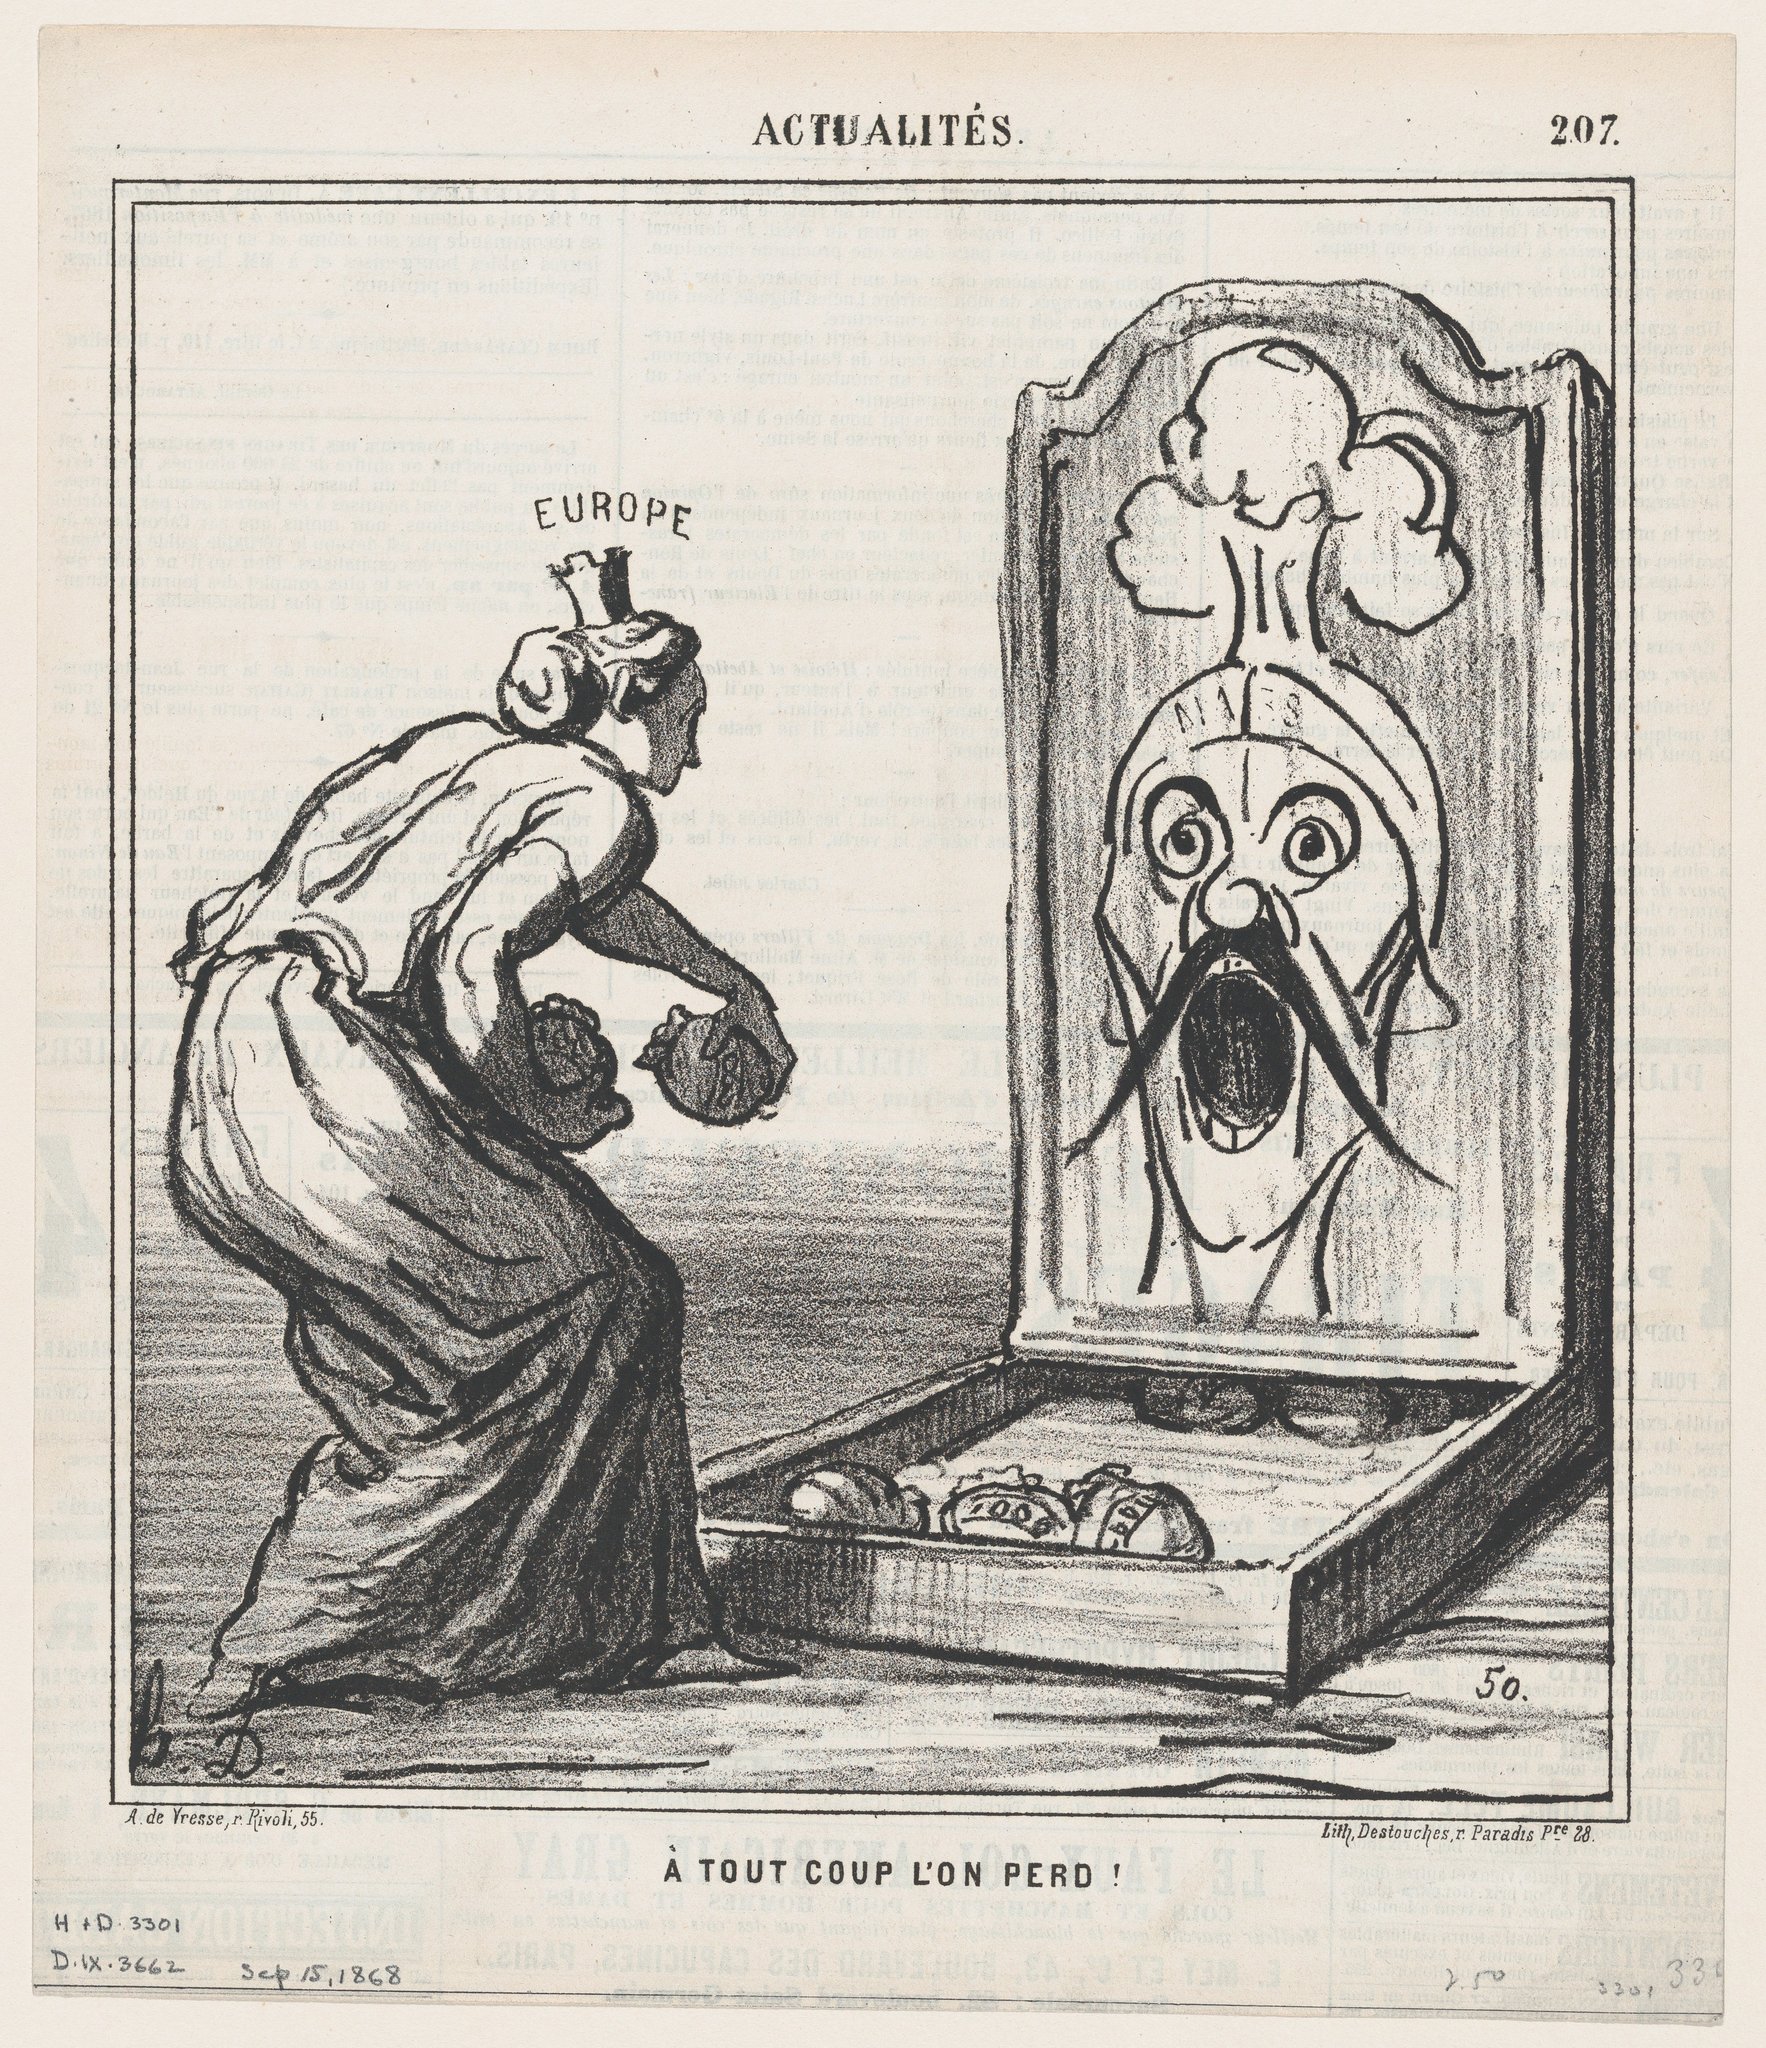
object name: print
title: Every toss loses, from "News of the Day"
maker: honoré daumier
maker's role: artist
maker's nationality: french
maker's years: 1808-1879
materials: paper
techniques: lithograph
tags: satire,women,playing